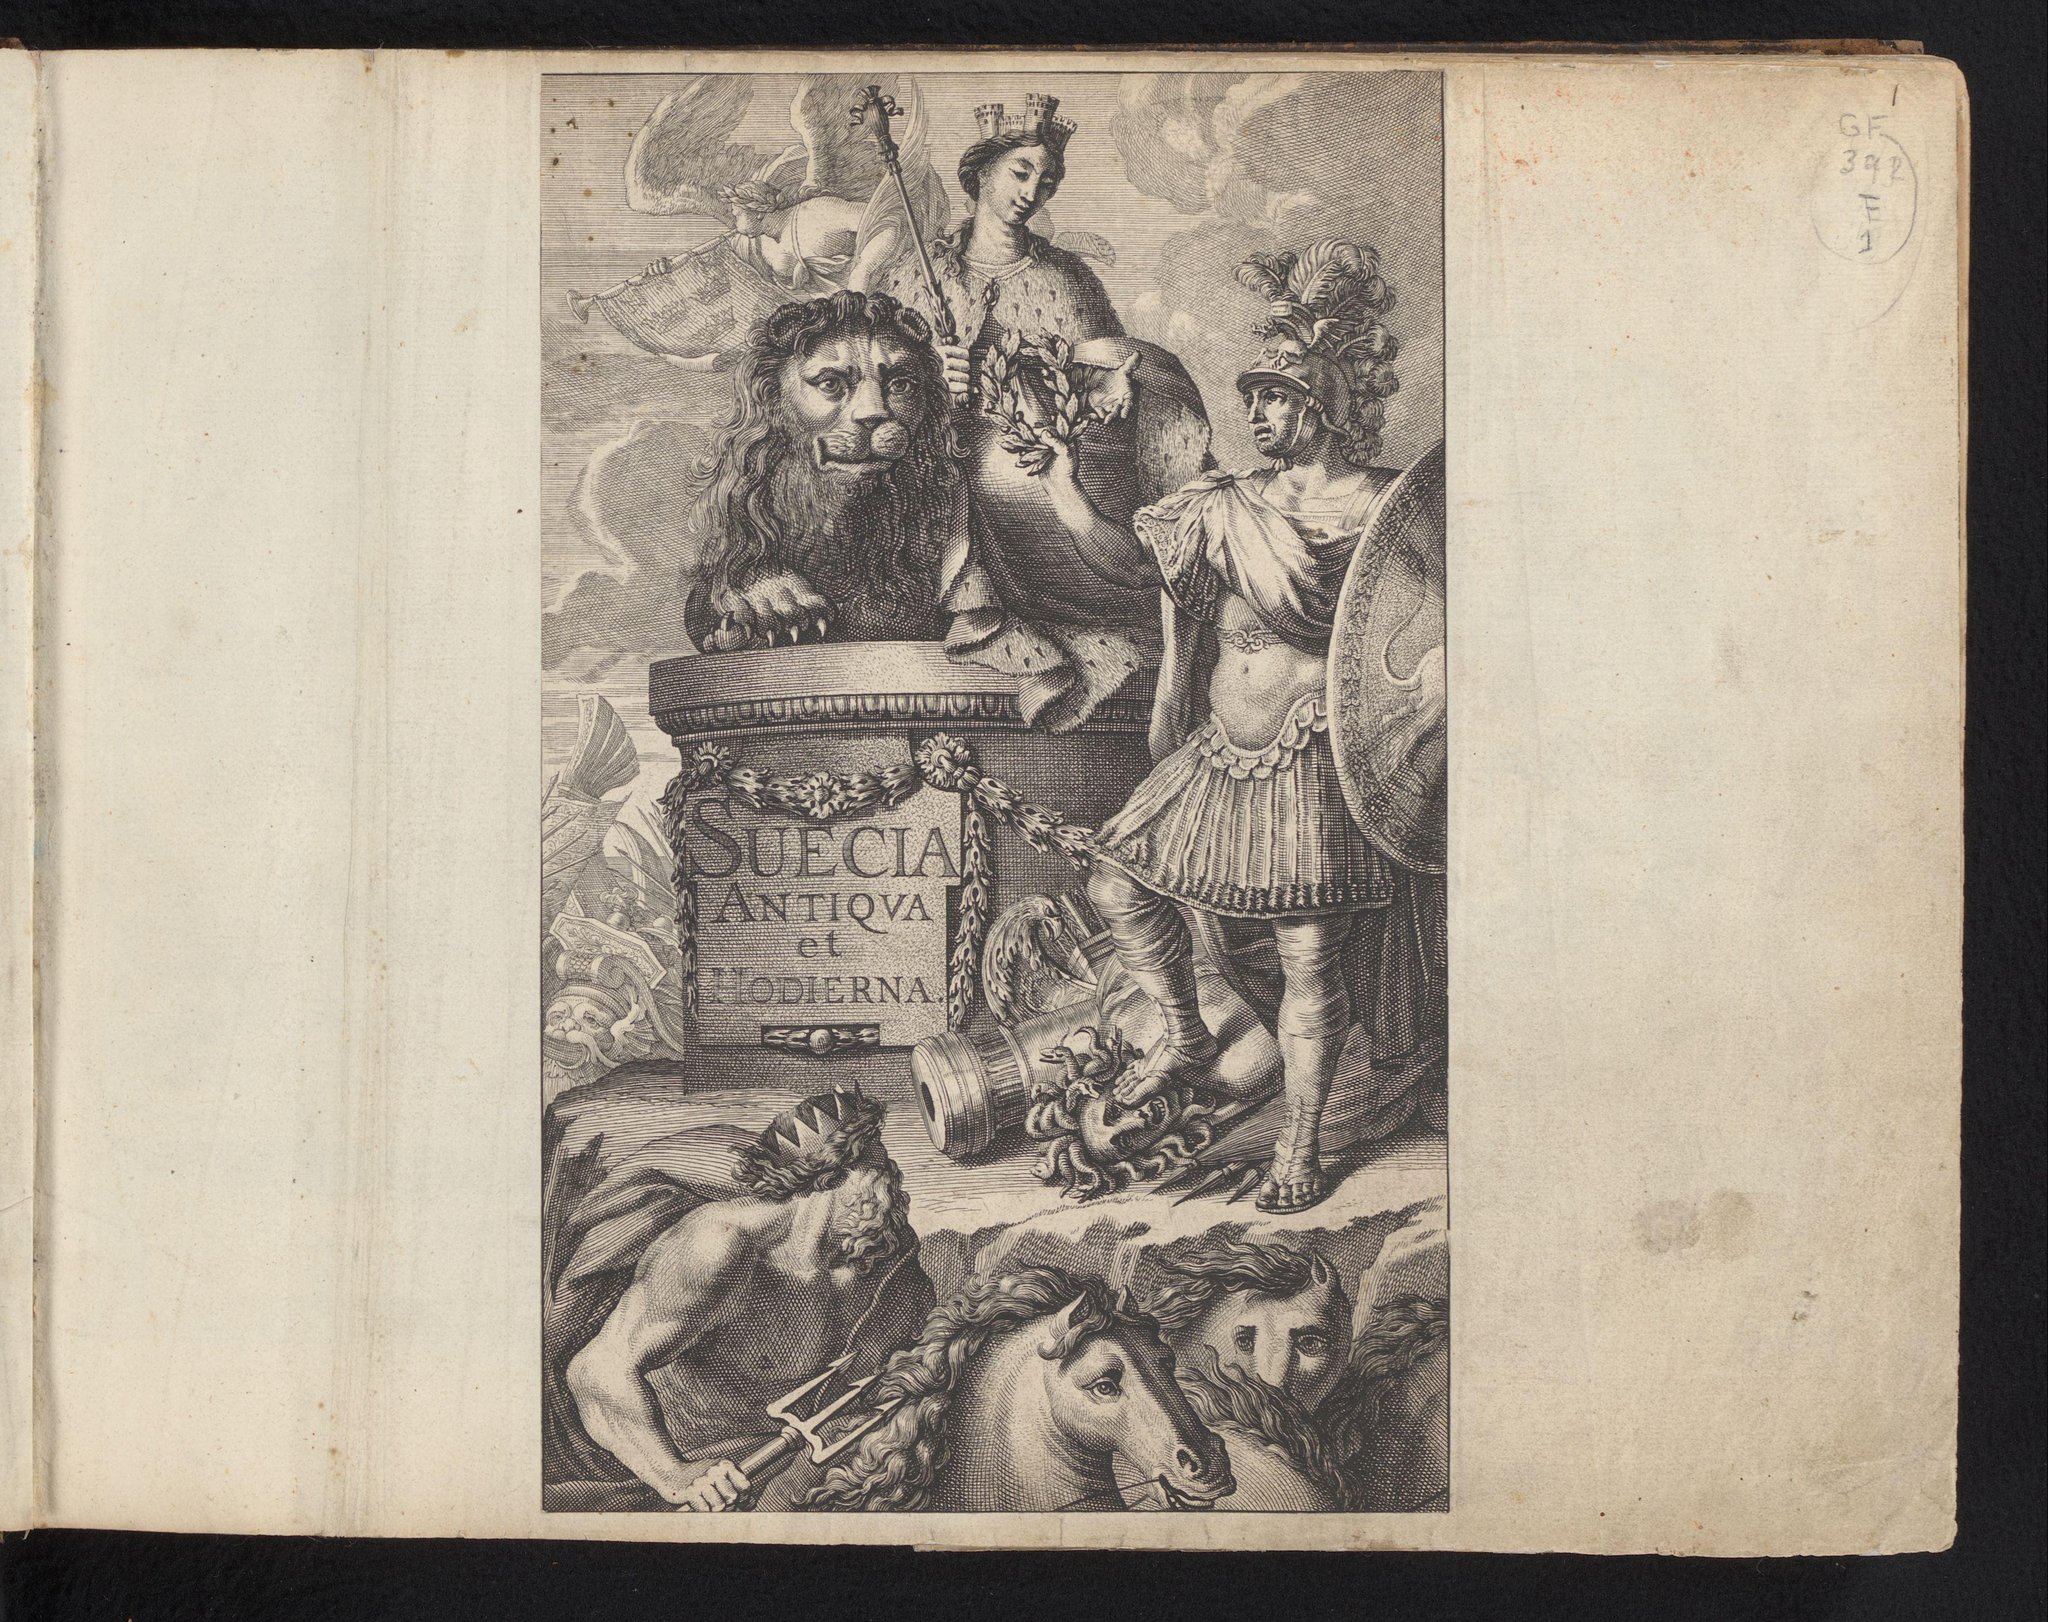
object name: titelprent, frontispice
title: Suecia Antiqua et Hodierna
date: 1669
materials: paper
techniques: engraving, etching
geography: paris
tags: (story of) neptune (poseidon), (story of) mars (ares), personifications of countries, nations, states, districts, etc., title-page, medusa (one of the gorgons), beasts of prey, predatory animals: lion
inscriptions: collector's mark: ‘RIJKS / MUSM’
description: Allegorische titelprent voor de reeks getiteld: Suecia antiqua et hodierna. Op een sokkel de vrouwelijke personificatie van het Zweedse Rijk, met een muurkroon op het hoofd en een scepter in de handen. Ze draagt een hermelijnen mantel en zit op een leeuw. De personificatie van de Oorlog vertrapt het kwaad en biedt het Zweedse rijk een krans van olijftakken aan. Daarachter blaast Faam op de loftrompet. Aan de trompet hangt een banner met wapen van Zweden. Op de voorgrond Neptunus. De prent maakt deel uit van een album.